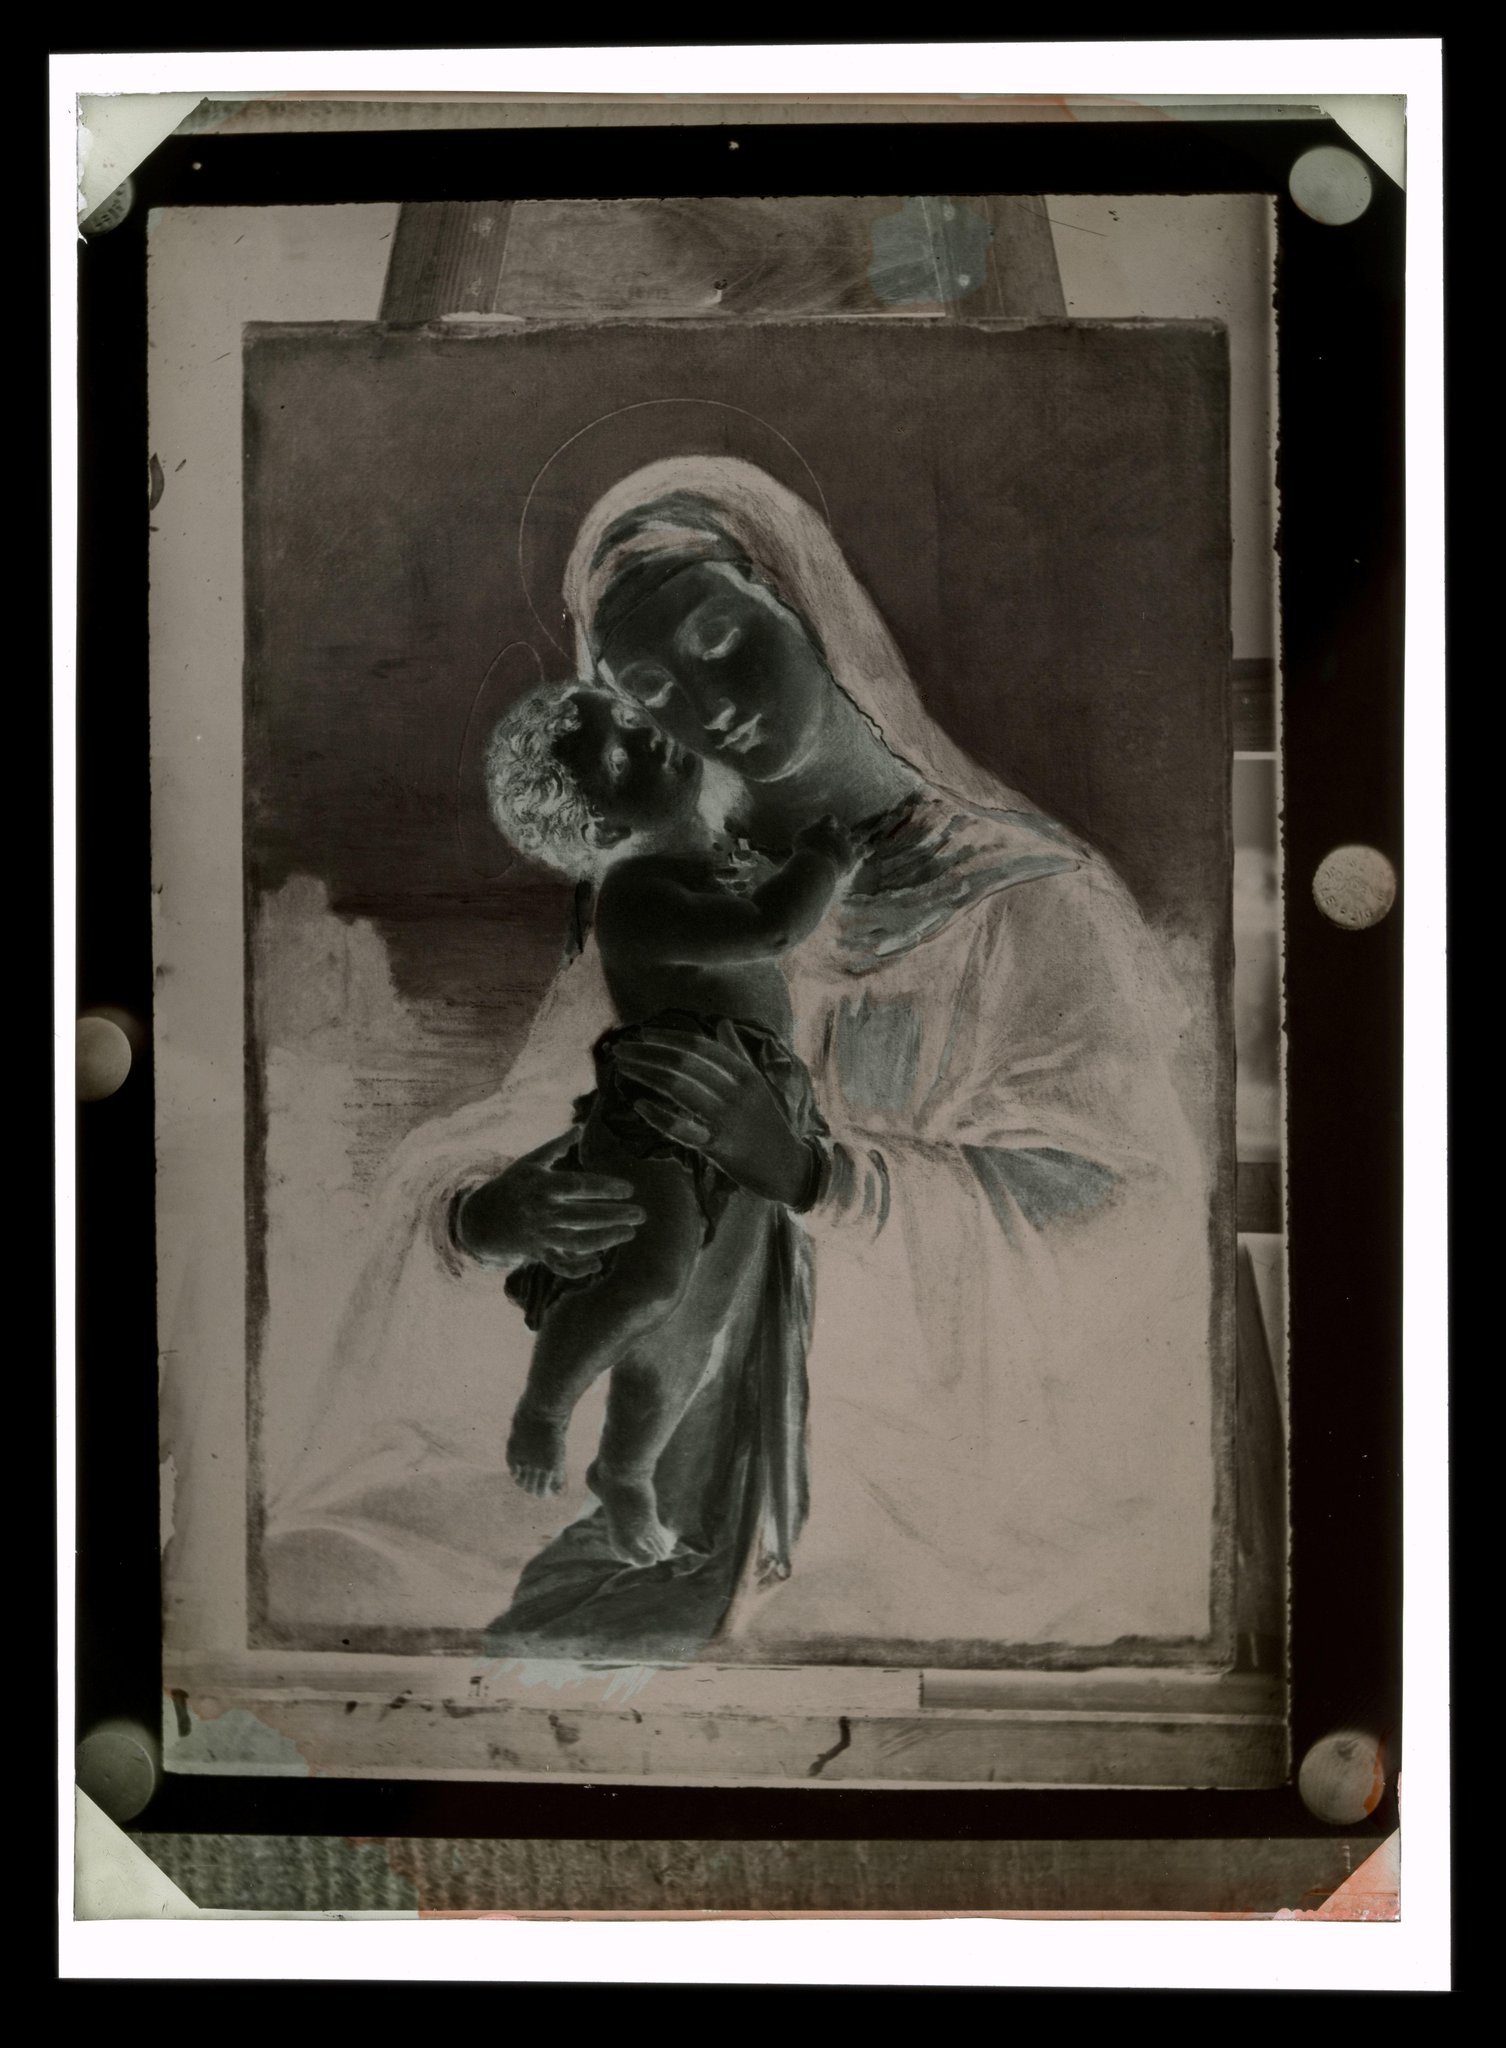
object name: glasnegatief, glasplaatnegatief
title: Fotoreproductie van een schilderij van Maria met Christus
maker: laurens lodewijk kleijn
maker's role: draughtsman, painter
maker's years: 1826-1909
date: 1865-1900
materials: glass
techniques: collodion process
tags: madonna: i.e. mary with the christ-child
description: Onderdeel van een groep glasnegatieven uit de nalatenschap van de schilder Laurens Lodewijk Kleijn, met stillevens, portretten, zelfportretten en kunstreproducties.